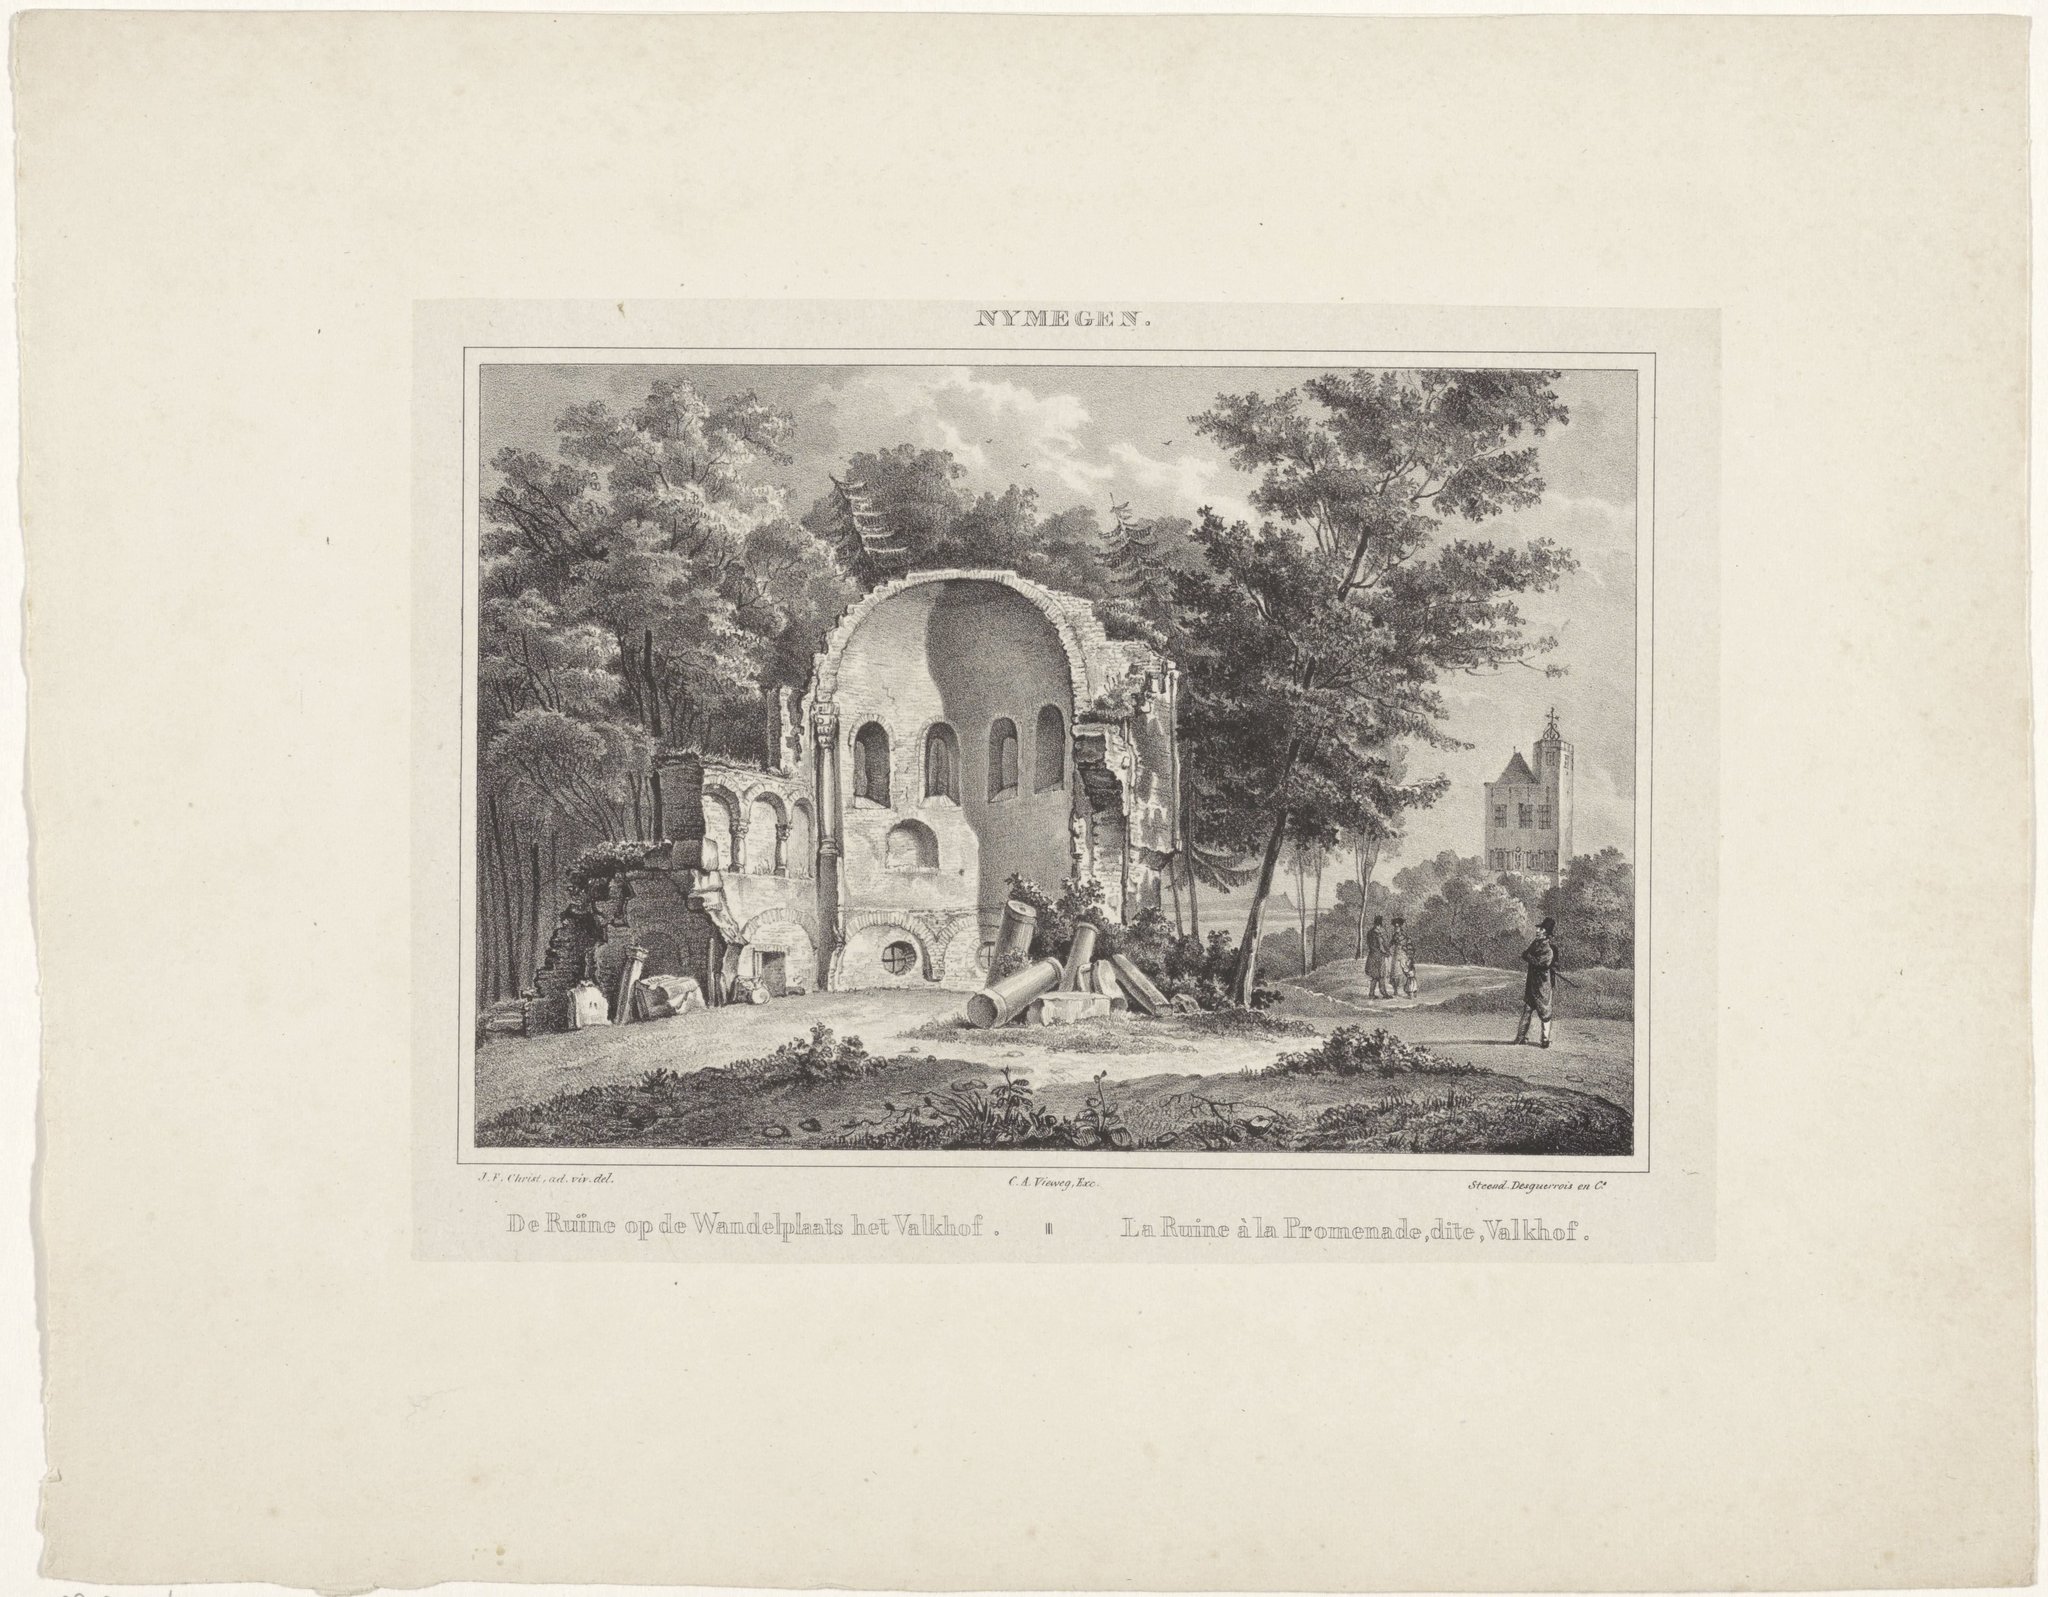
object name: print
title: Nymegen.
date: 1834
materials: paper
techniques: lithograph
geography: nijmegen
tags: landscape with ruins, nijmegen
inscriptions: collector's mark: Lugt 2228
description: De ruïne ligt tussen de bomen en is begroeid. Er omheen liggen brokstukken van zuilen en kapitelen. Rechts staat een figuur naar de ruïne te kijken. Achter hem, in de verte, het Belvédère.